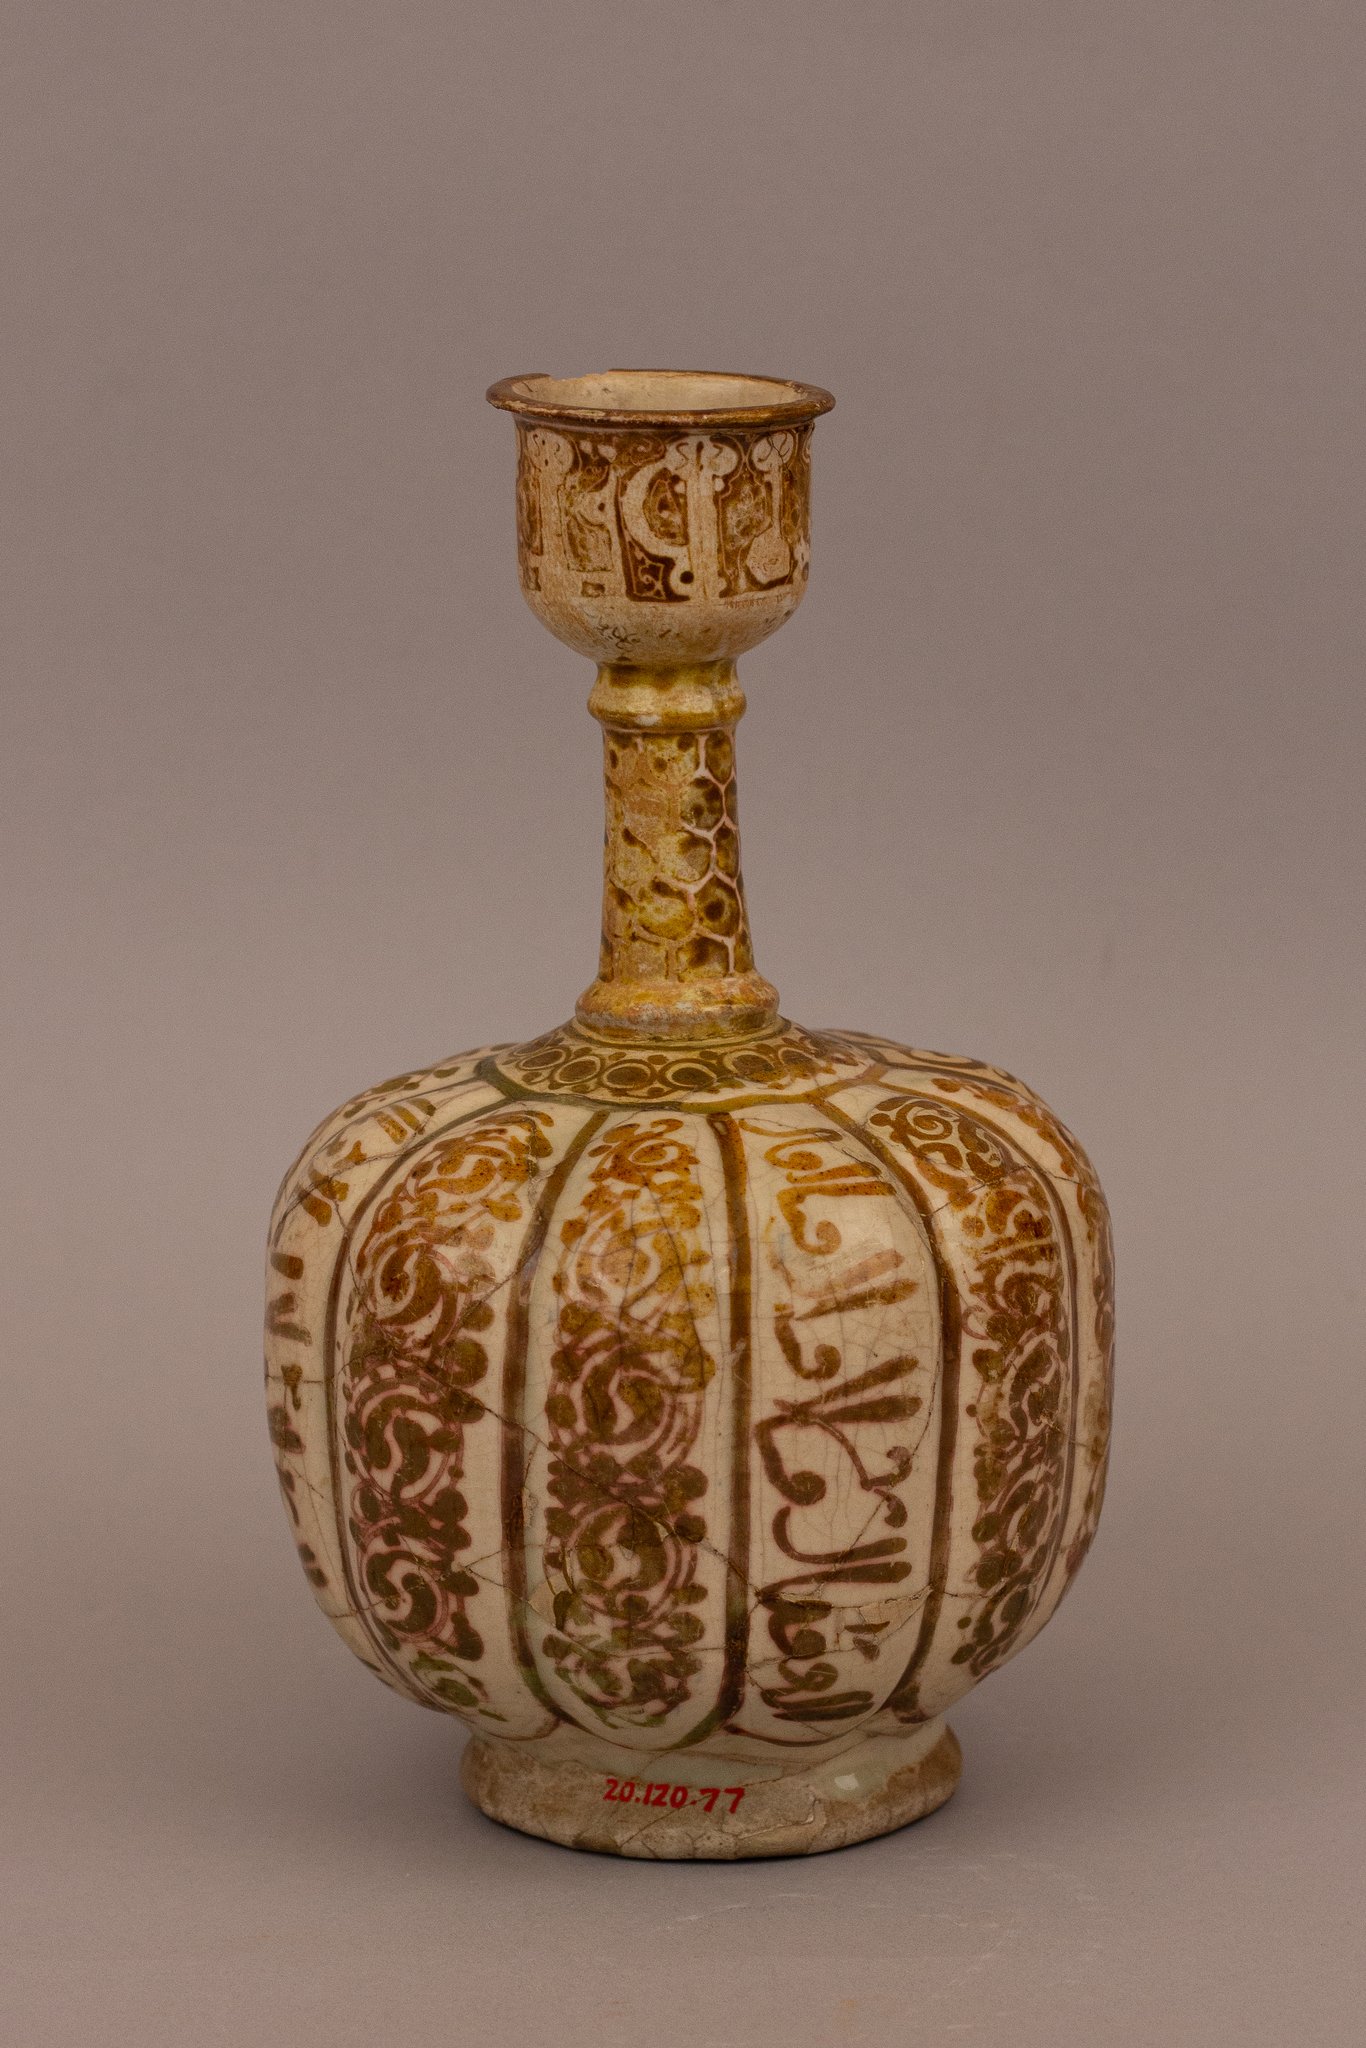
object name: ewer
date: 1101-1300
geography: iran